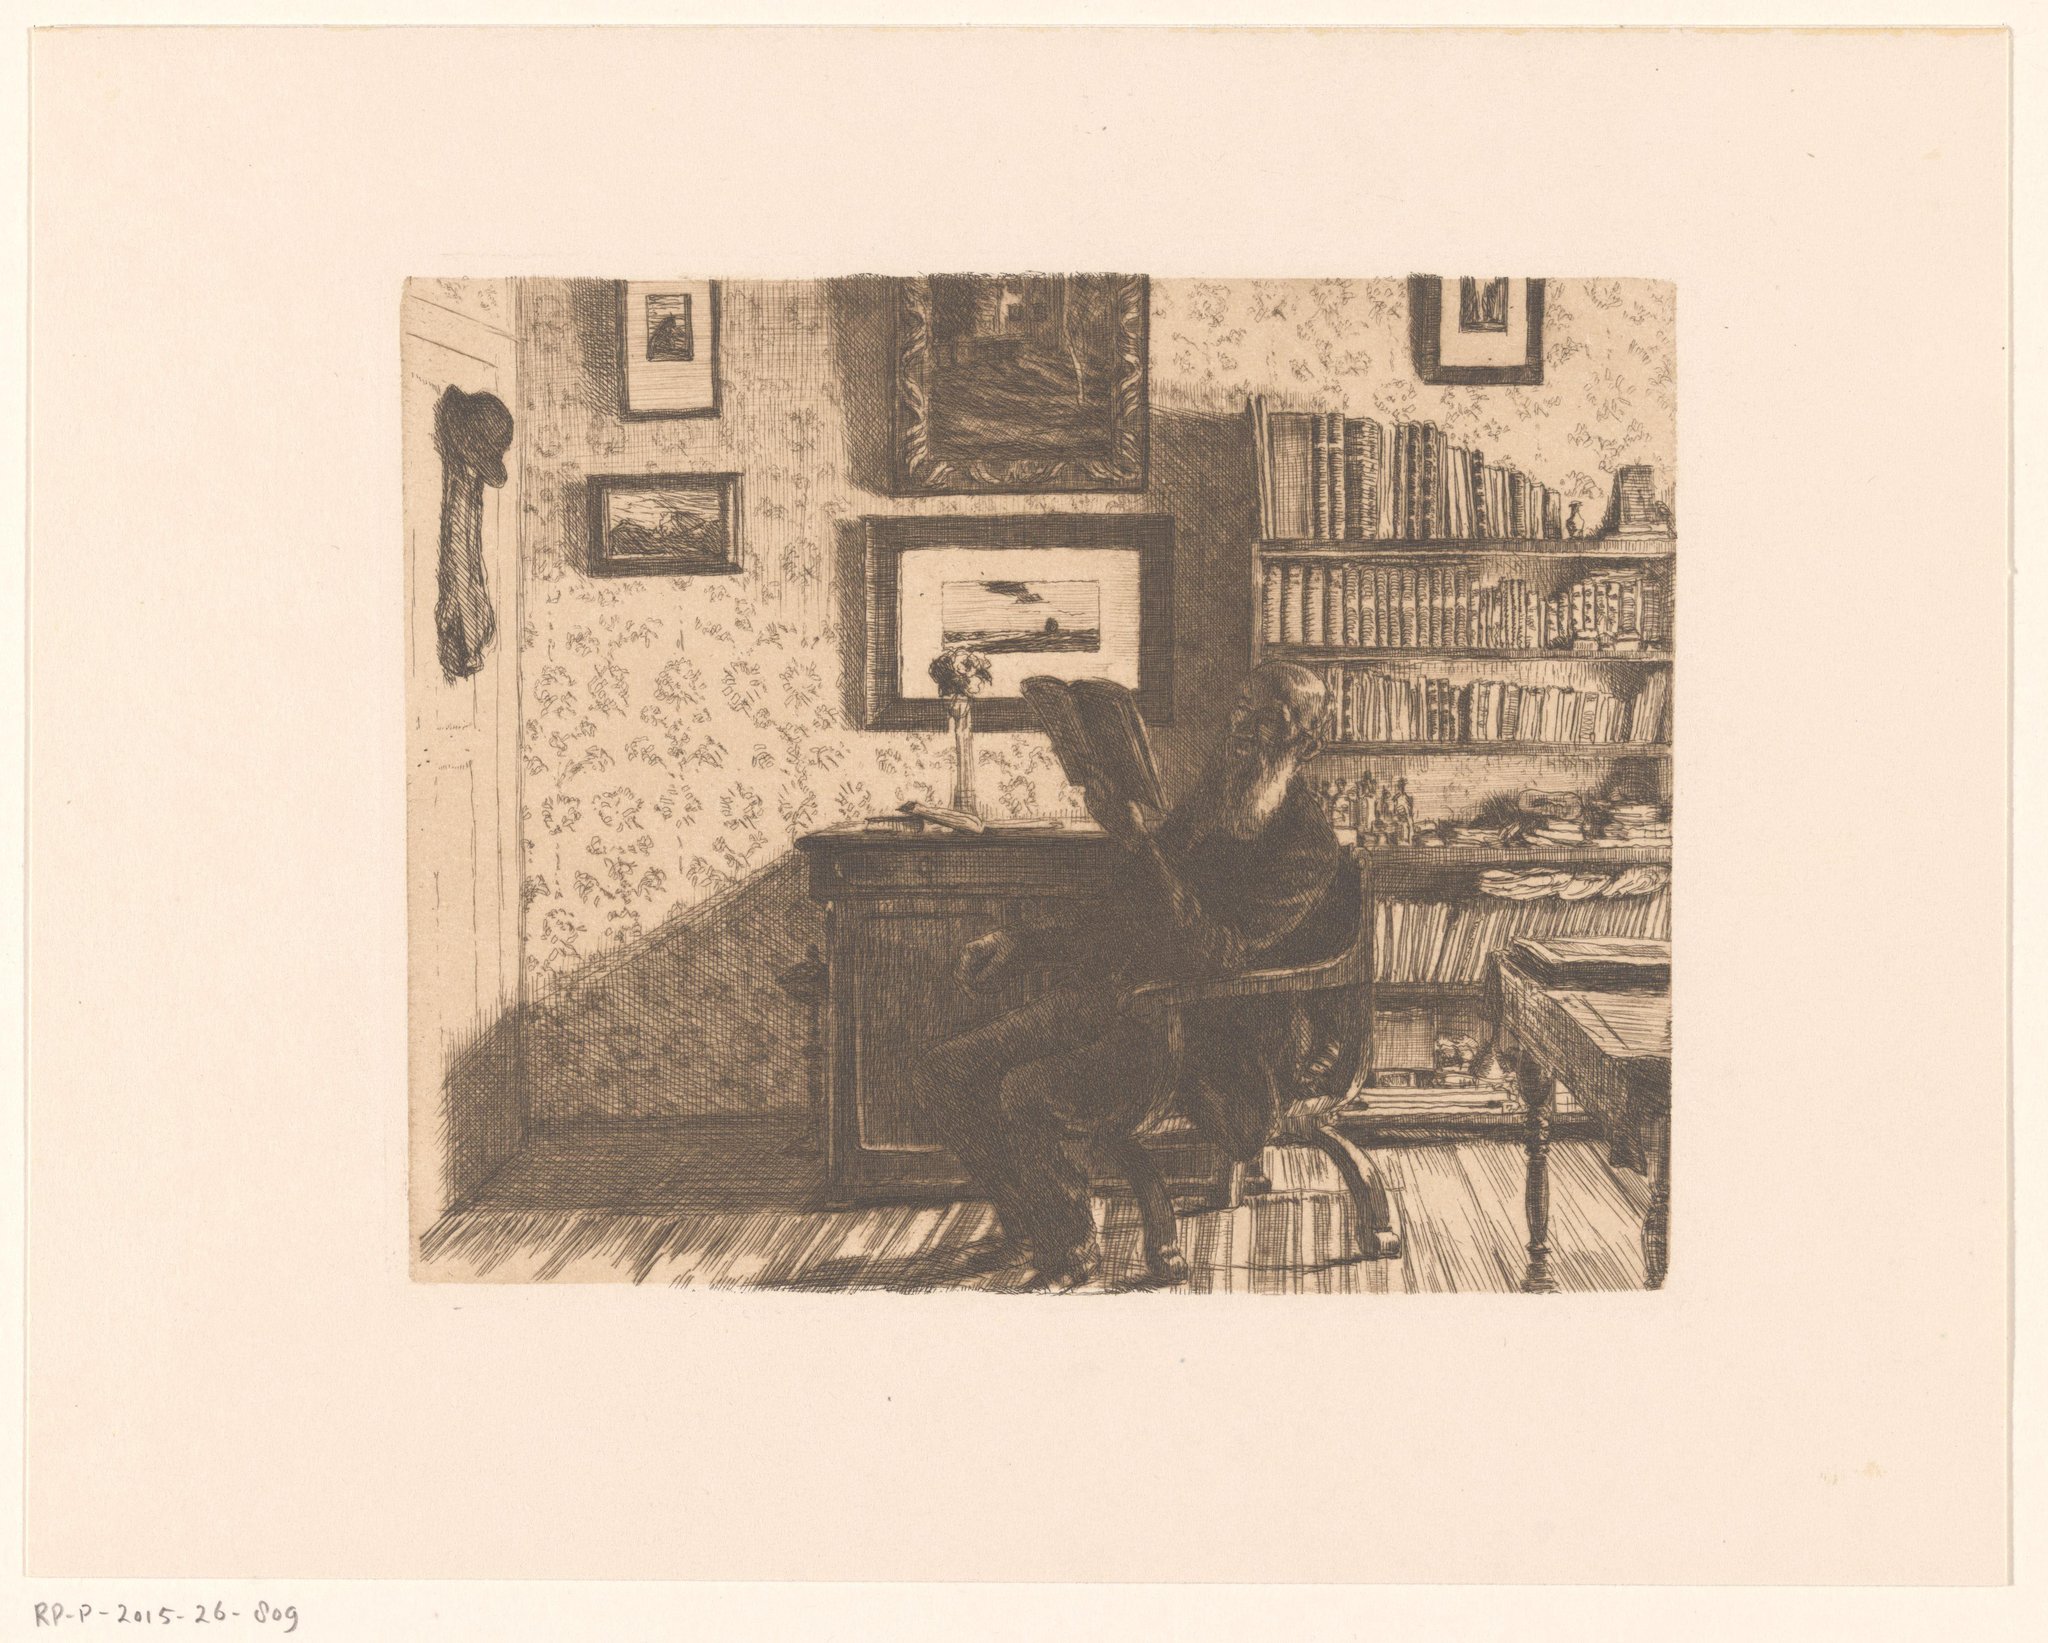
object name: print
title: Lezende man in een interieur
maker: heinrich reifferscheid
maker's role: print maker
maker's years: 1872-1945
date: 1882-1940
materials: paper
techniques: drypoint, etching, intaglio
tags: bookshelves, newspaper, news-sheet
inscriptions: collector's mark: Lugt 2228, collector's mark: Lugt 4779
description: In het midden van de kamer zit een kale man met een baard te lezen in een stoel. Achter hem staat een boekenkast, aan de wand hangen ingelijste werken.